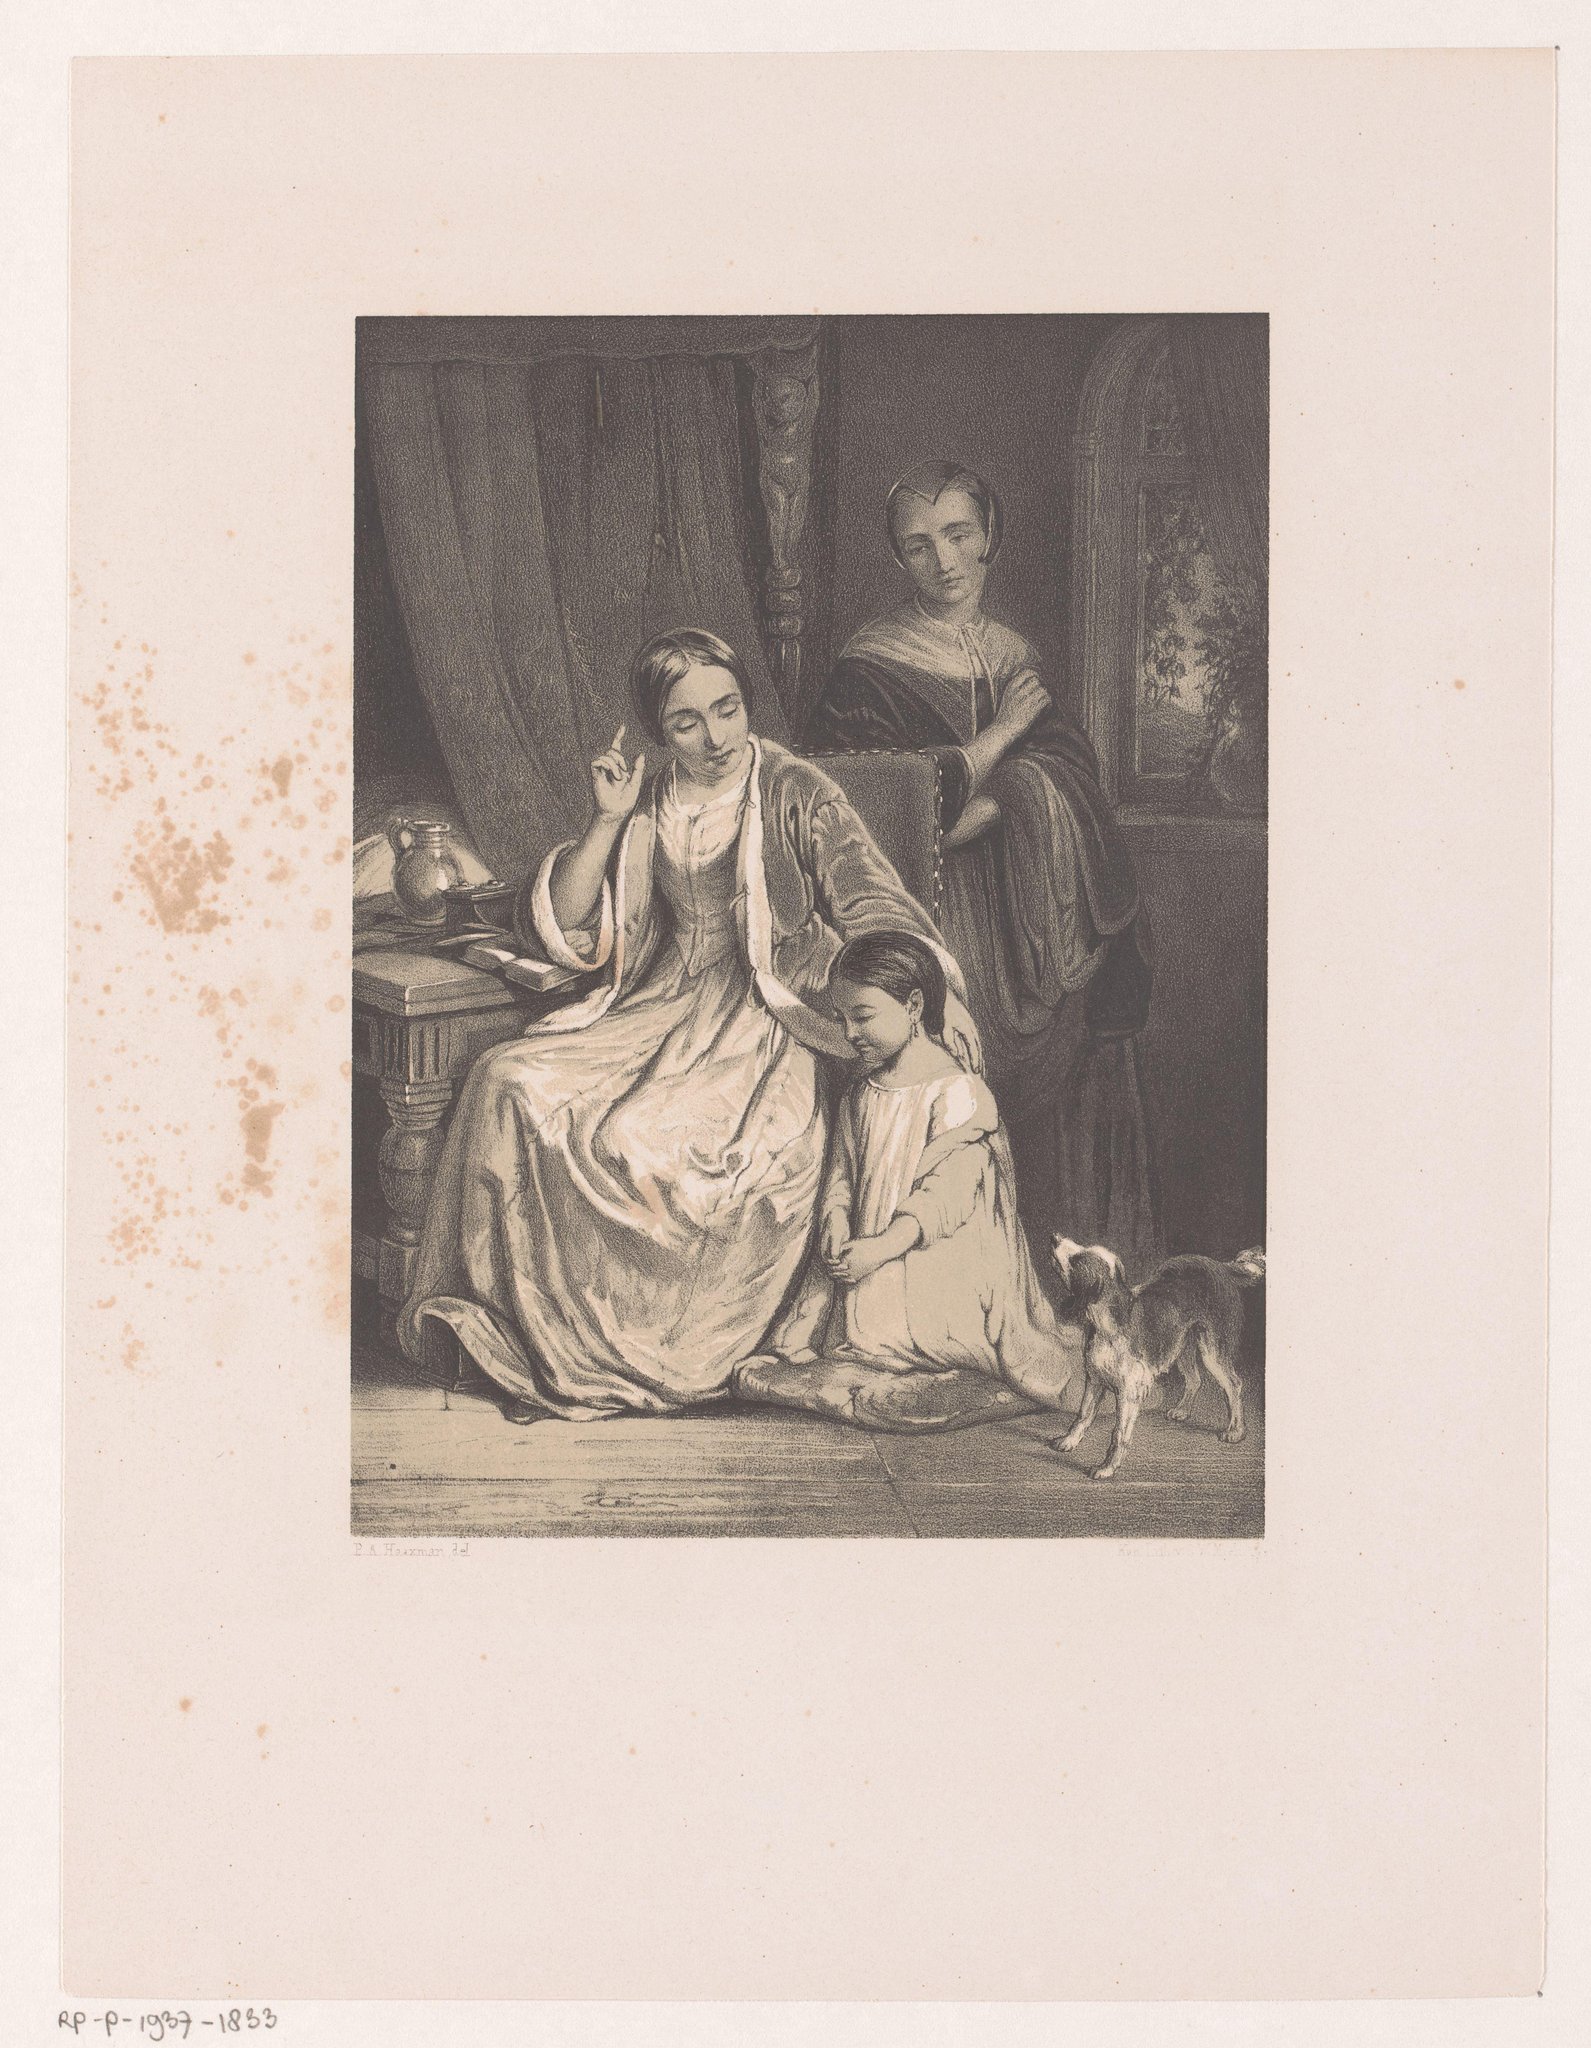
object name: print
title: Twee vrouwen en biddend meisje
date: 1847-1866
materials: paper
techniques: tone lithography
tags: bed, one person praying, dog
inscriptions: collector's mark: Lugt 2760, collector's mark: Lugt 2228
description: Het meisje zit geknield op een kussen, naast haar een hond. Links van de vrouwen een bed.